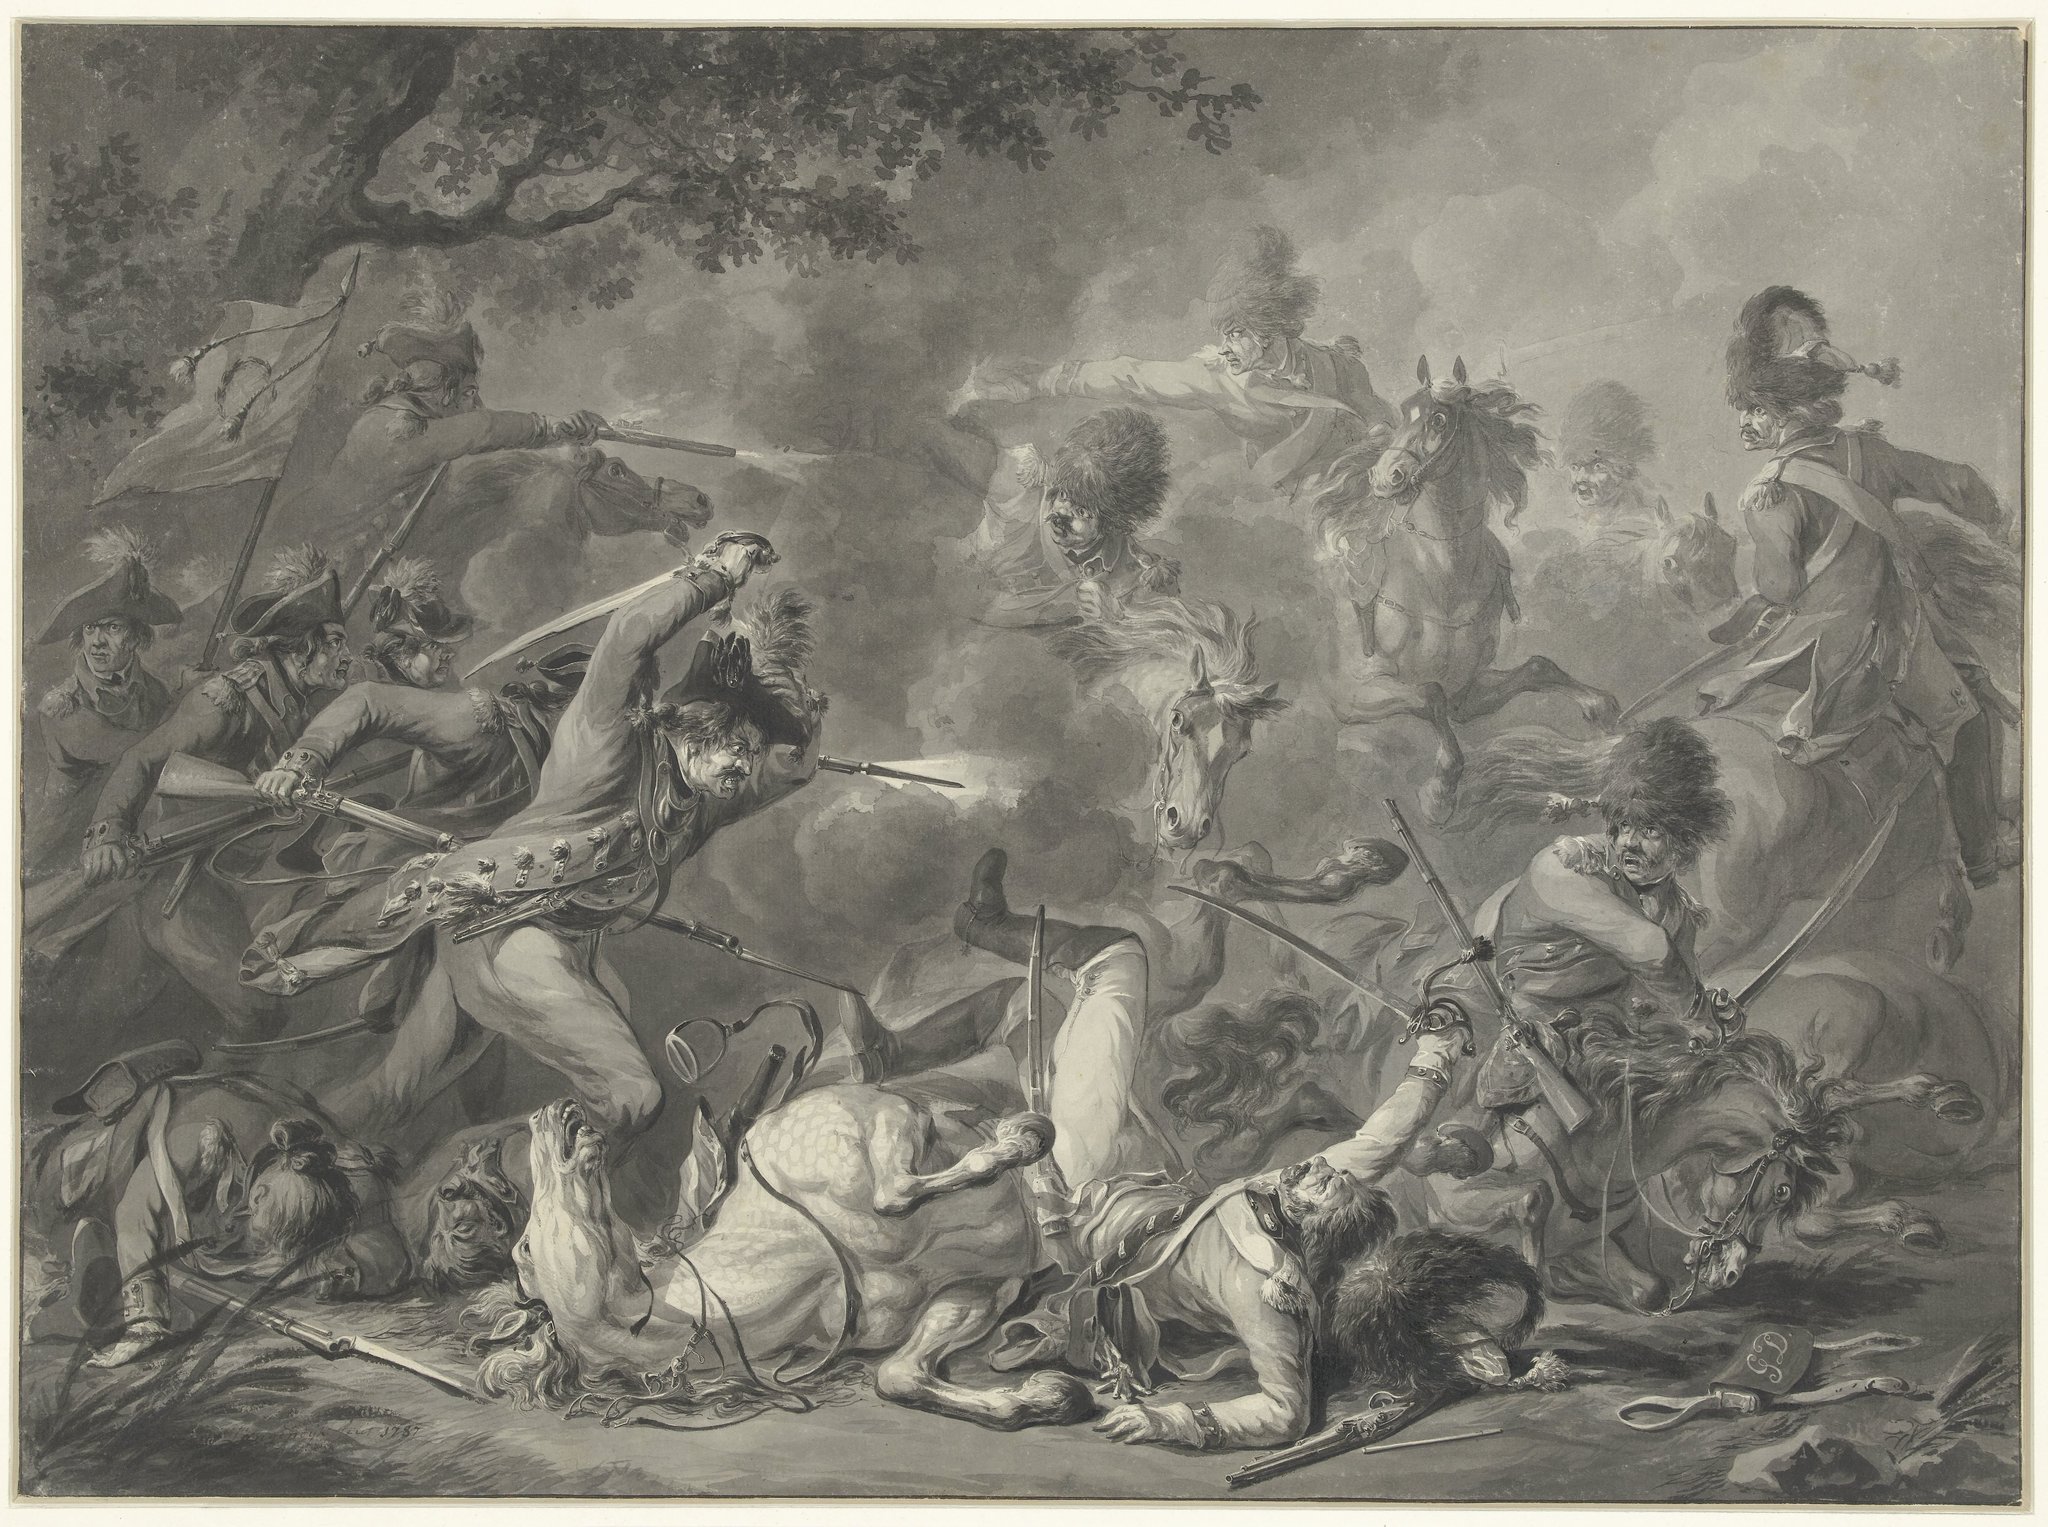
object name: drawing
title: Gevecht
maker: dirk langendijk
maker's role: draughtsman, painter, print maker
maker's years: 1748-1805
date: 1787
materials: ink, paper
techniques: brush, pen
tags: battle (+ during the battle)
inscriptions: date: ‘1787’